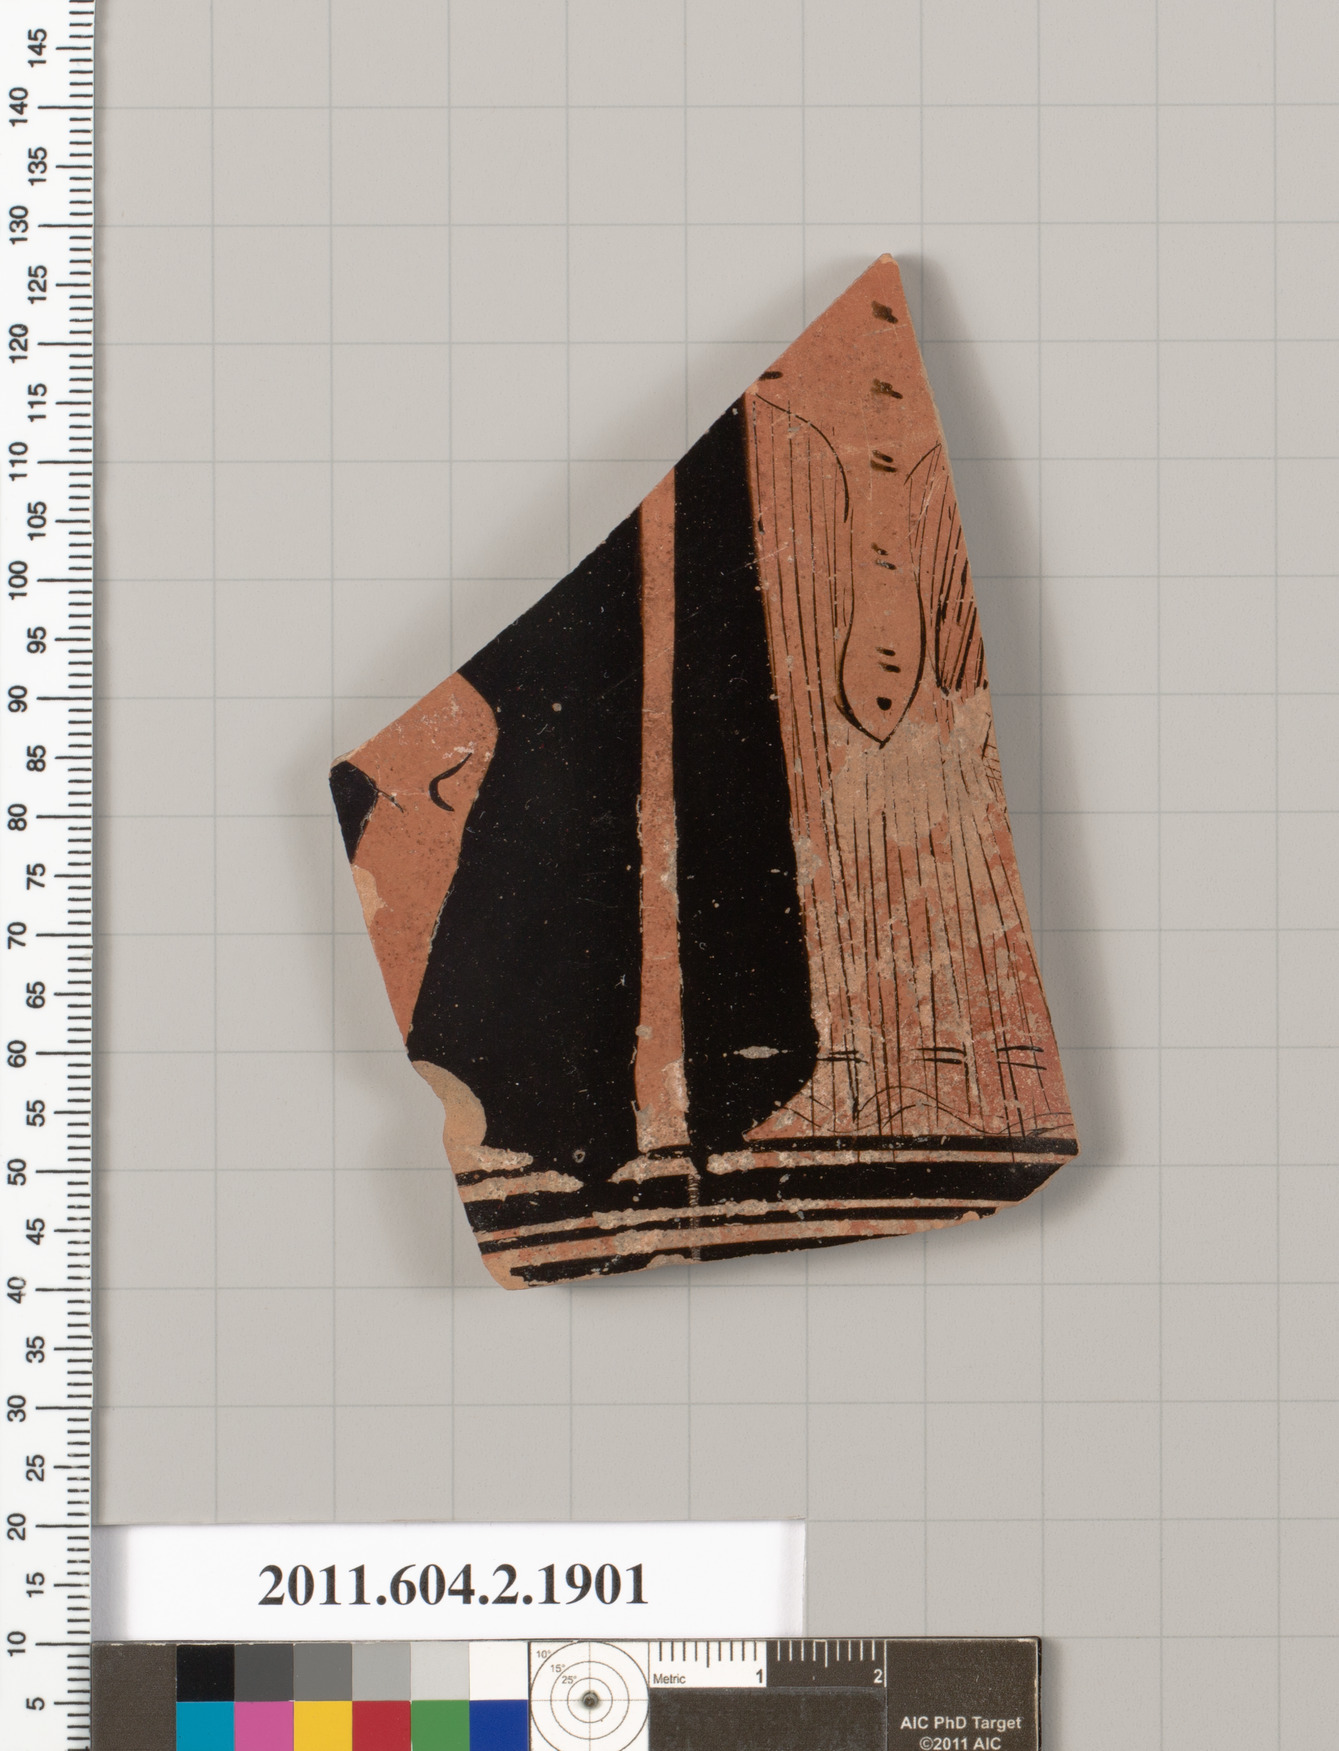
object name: skyphos fragment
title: Terracotta fragment of a skyphos (deep drinking cup)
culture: greek, attic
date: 430-400 BCE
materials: terracotta